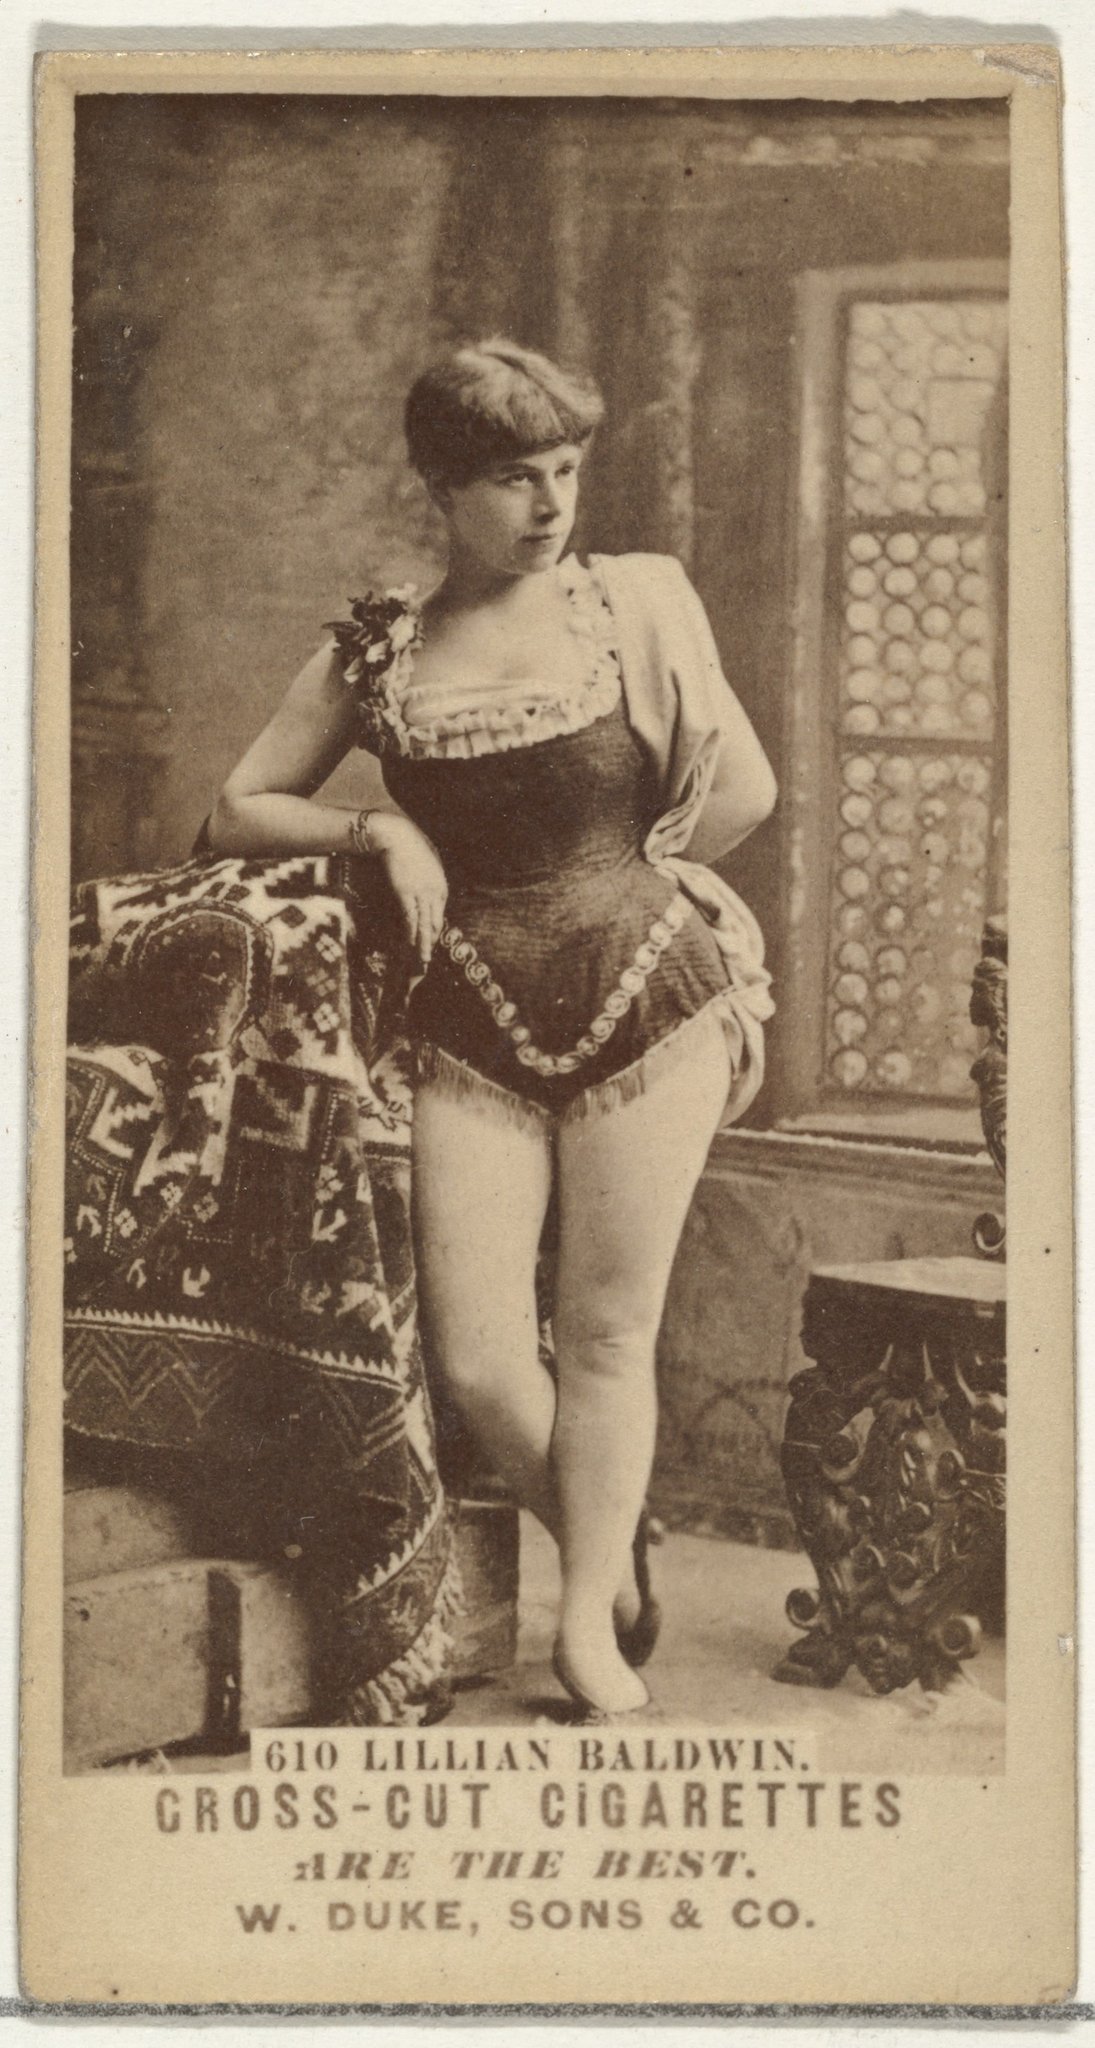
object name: photograph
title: Card Number 610, Lillian Baldwin, from the Actors and Actresses series (N145-3) issued by Duke Sons & Co. to promote Cross Cut Cigarettes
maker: w. duke, sons & co.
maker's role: publisher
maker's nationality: american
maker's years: 1870-1920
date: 1880-1889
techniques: albumen silver print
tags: portraits,women,actresses